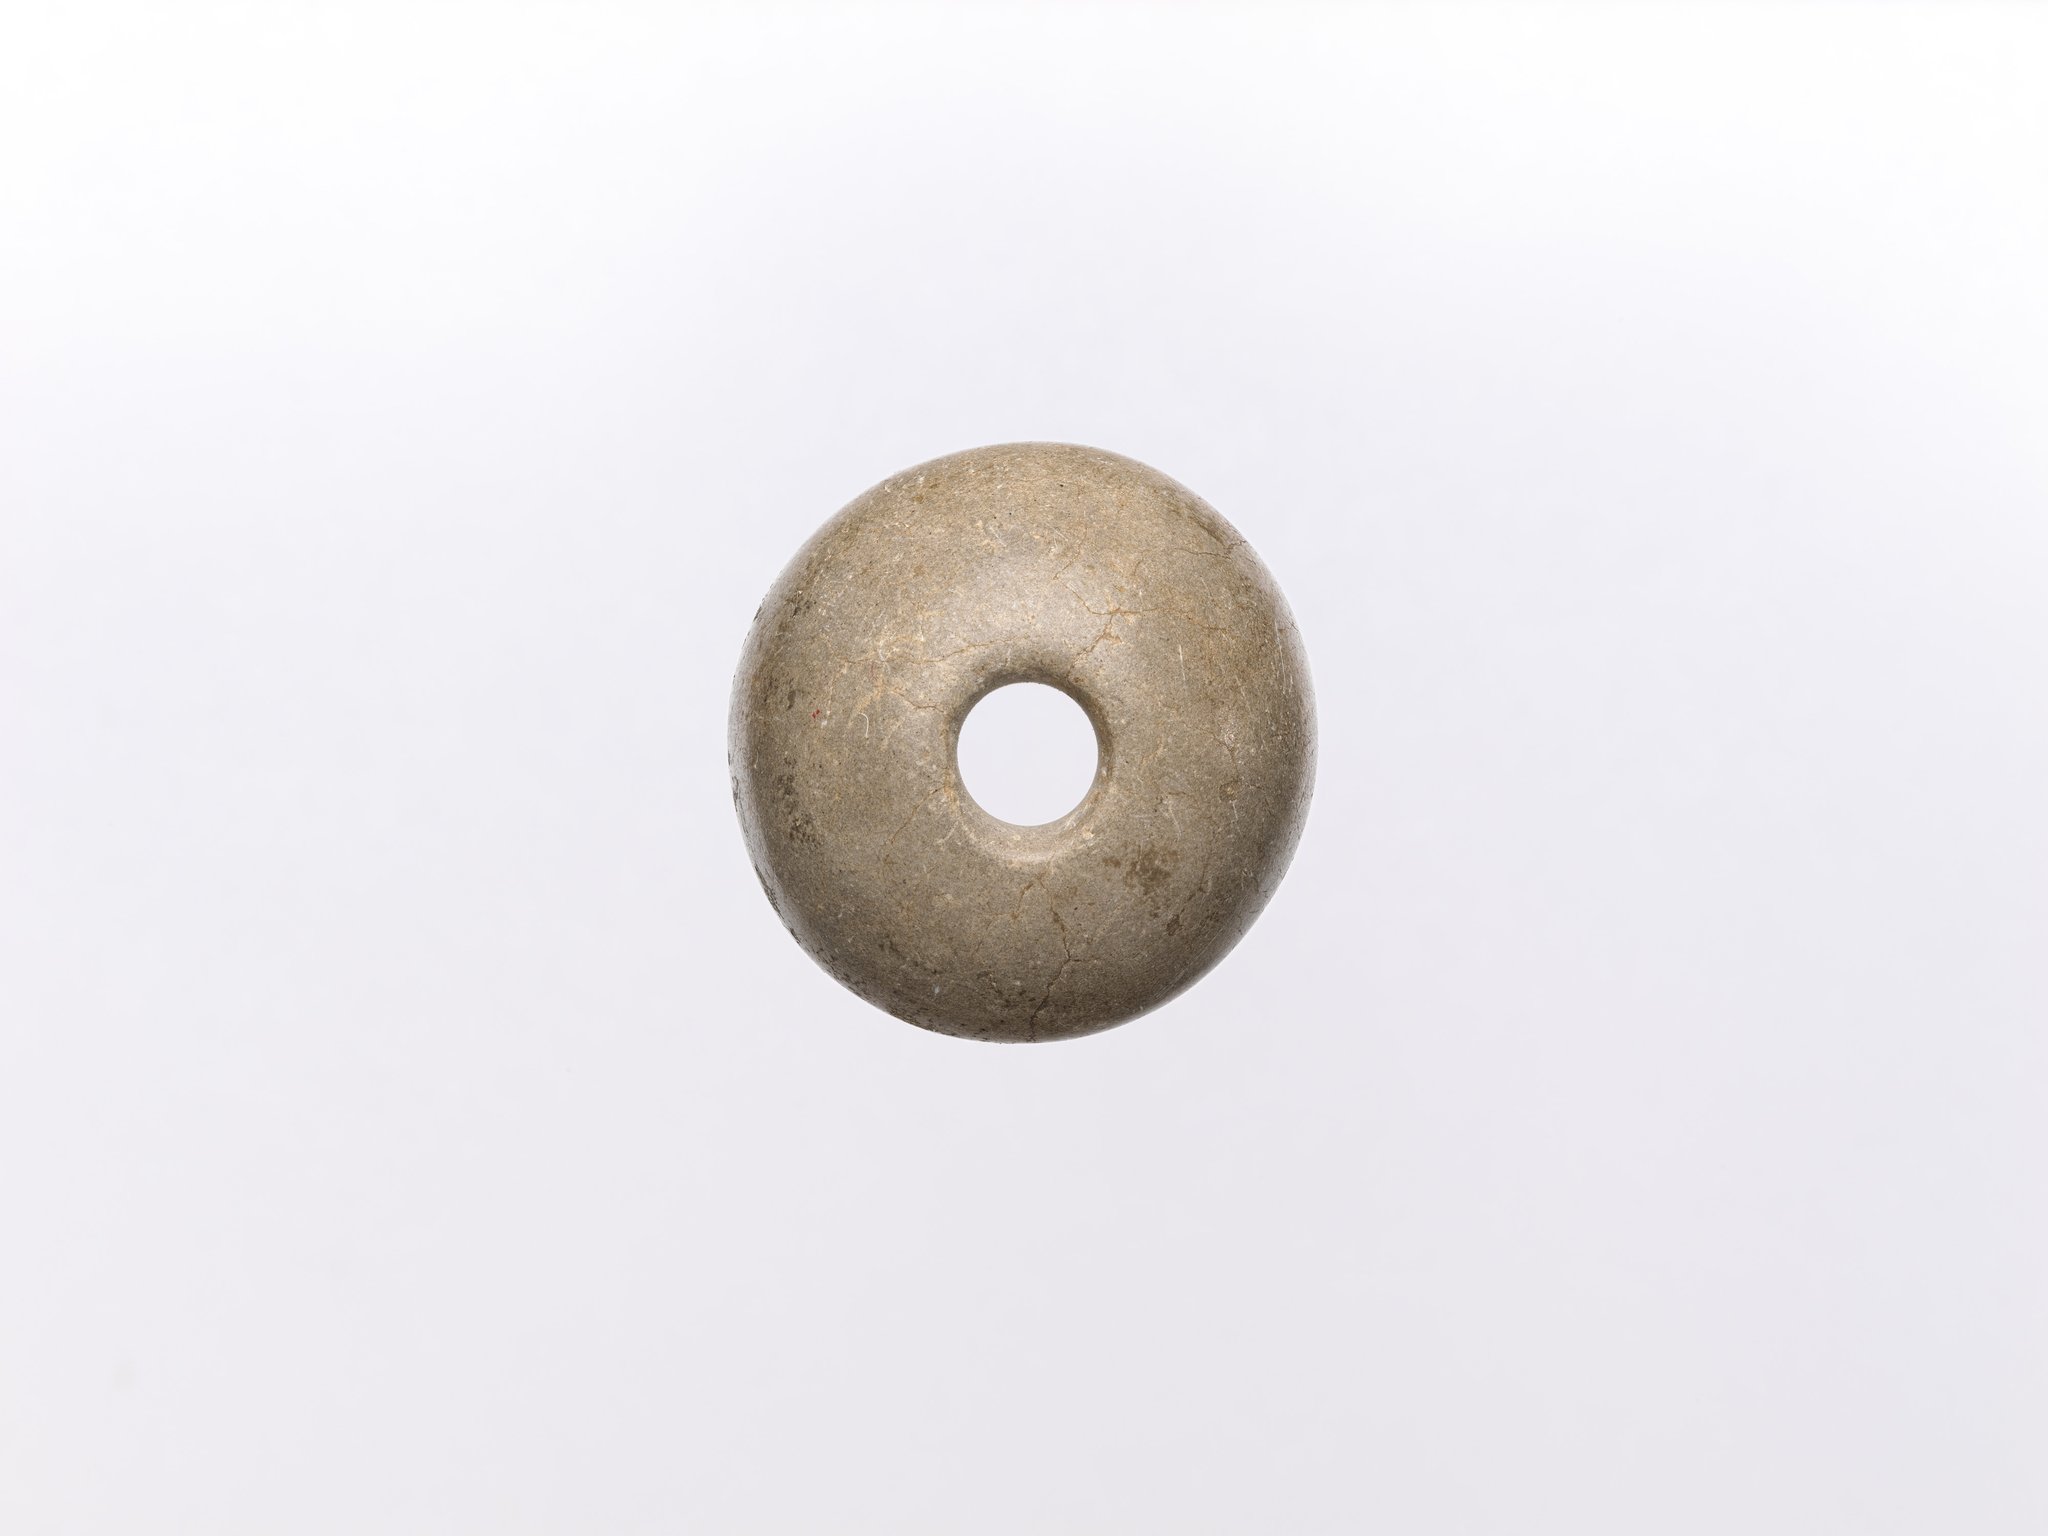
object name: whorl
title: Spindle whorl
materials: stone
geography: mesopotamia